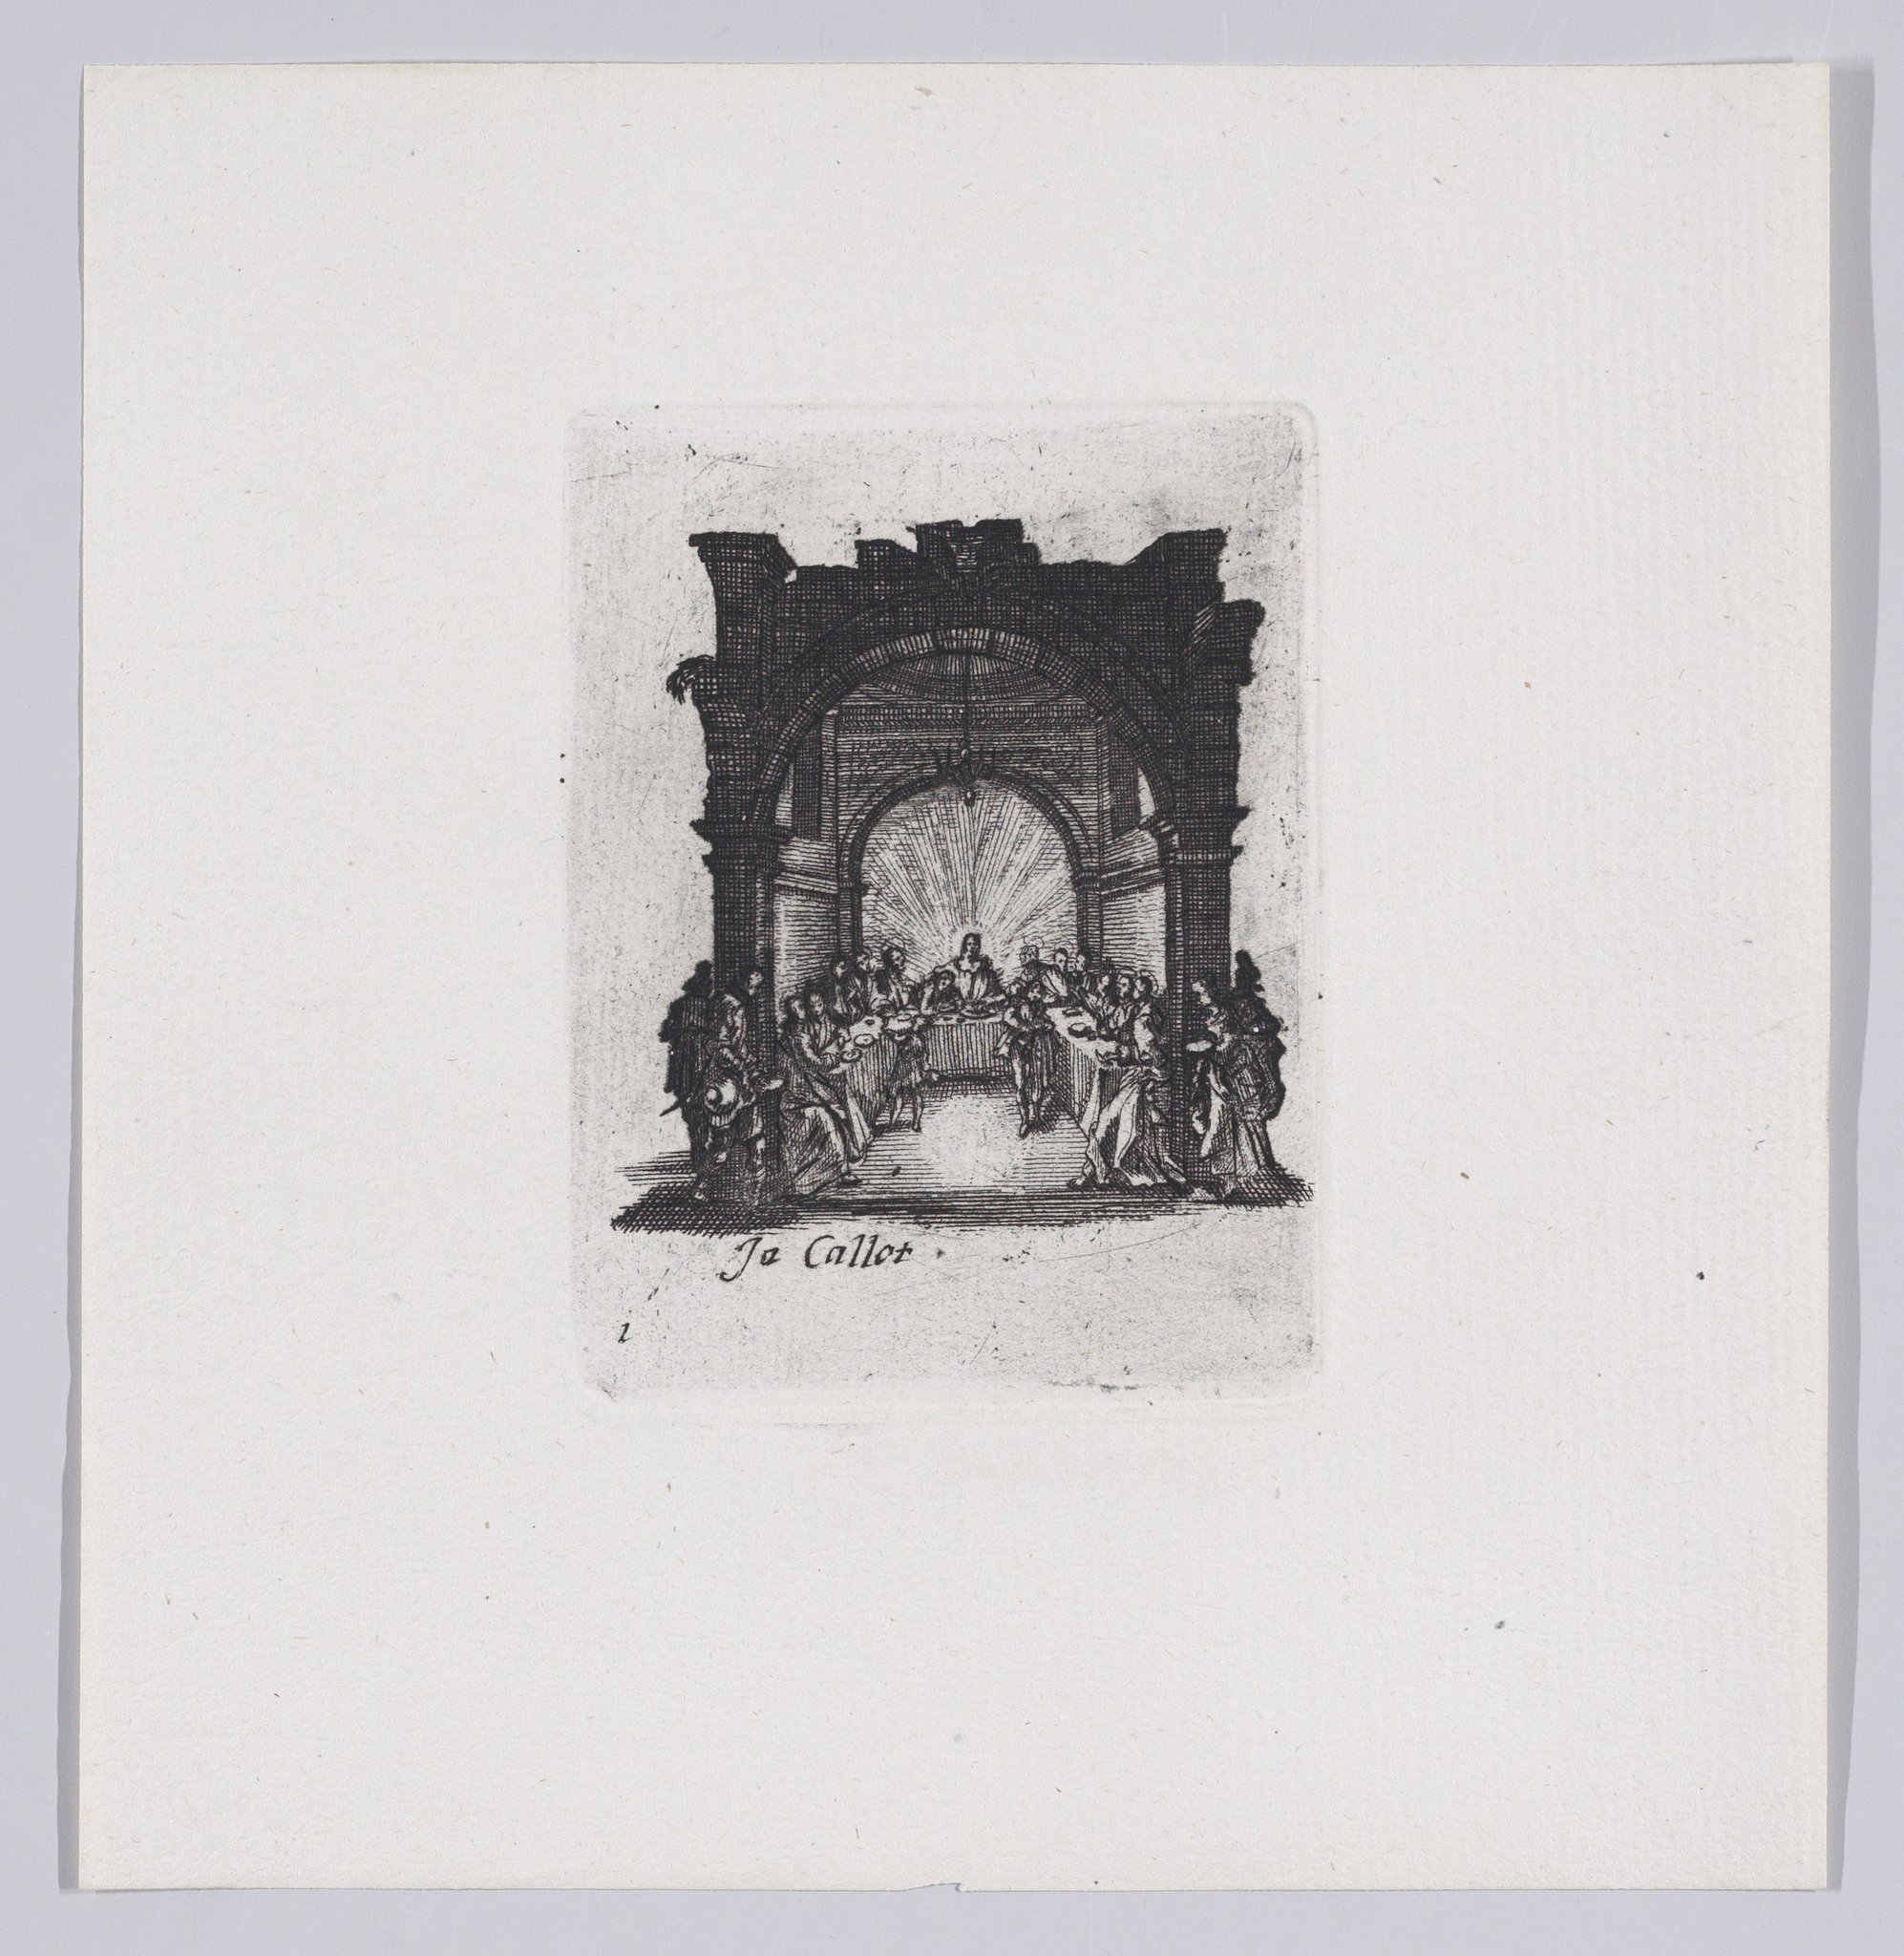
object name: print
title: Reverse Copy of La Cène (The Last Supper), from La Petite Passion (The Little Passion)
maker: Anonymous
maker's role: artist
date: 1601-1700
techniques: etching